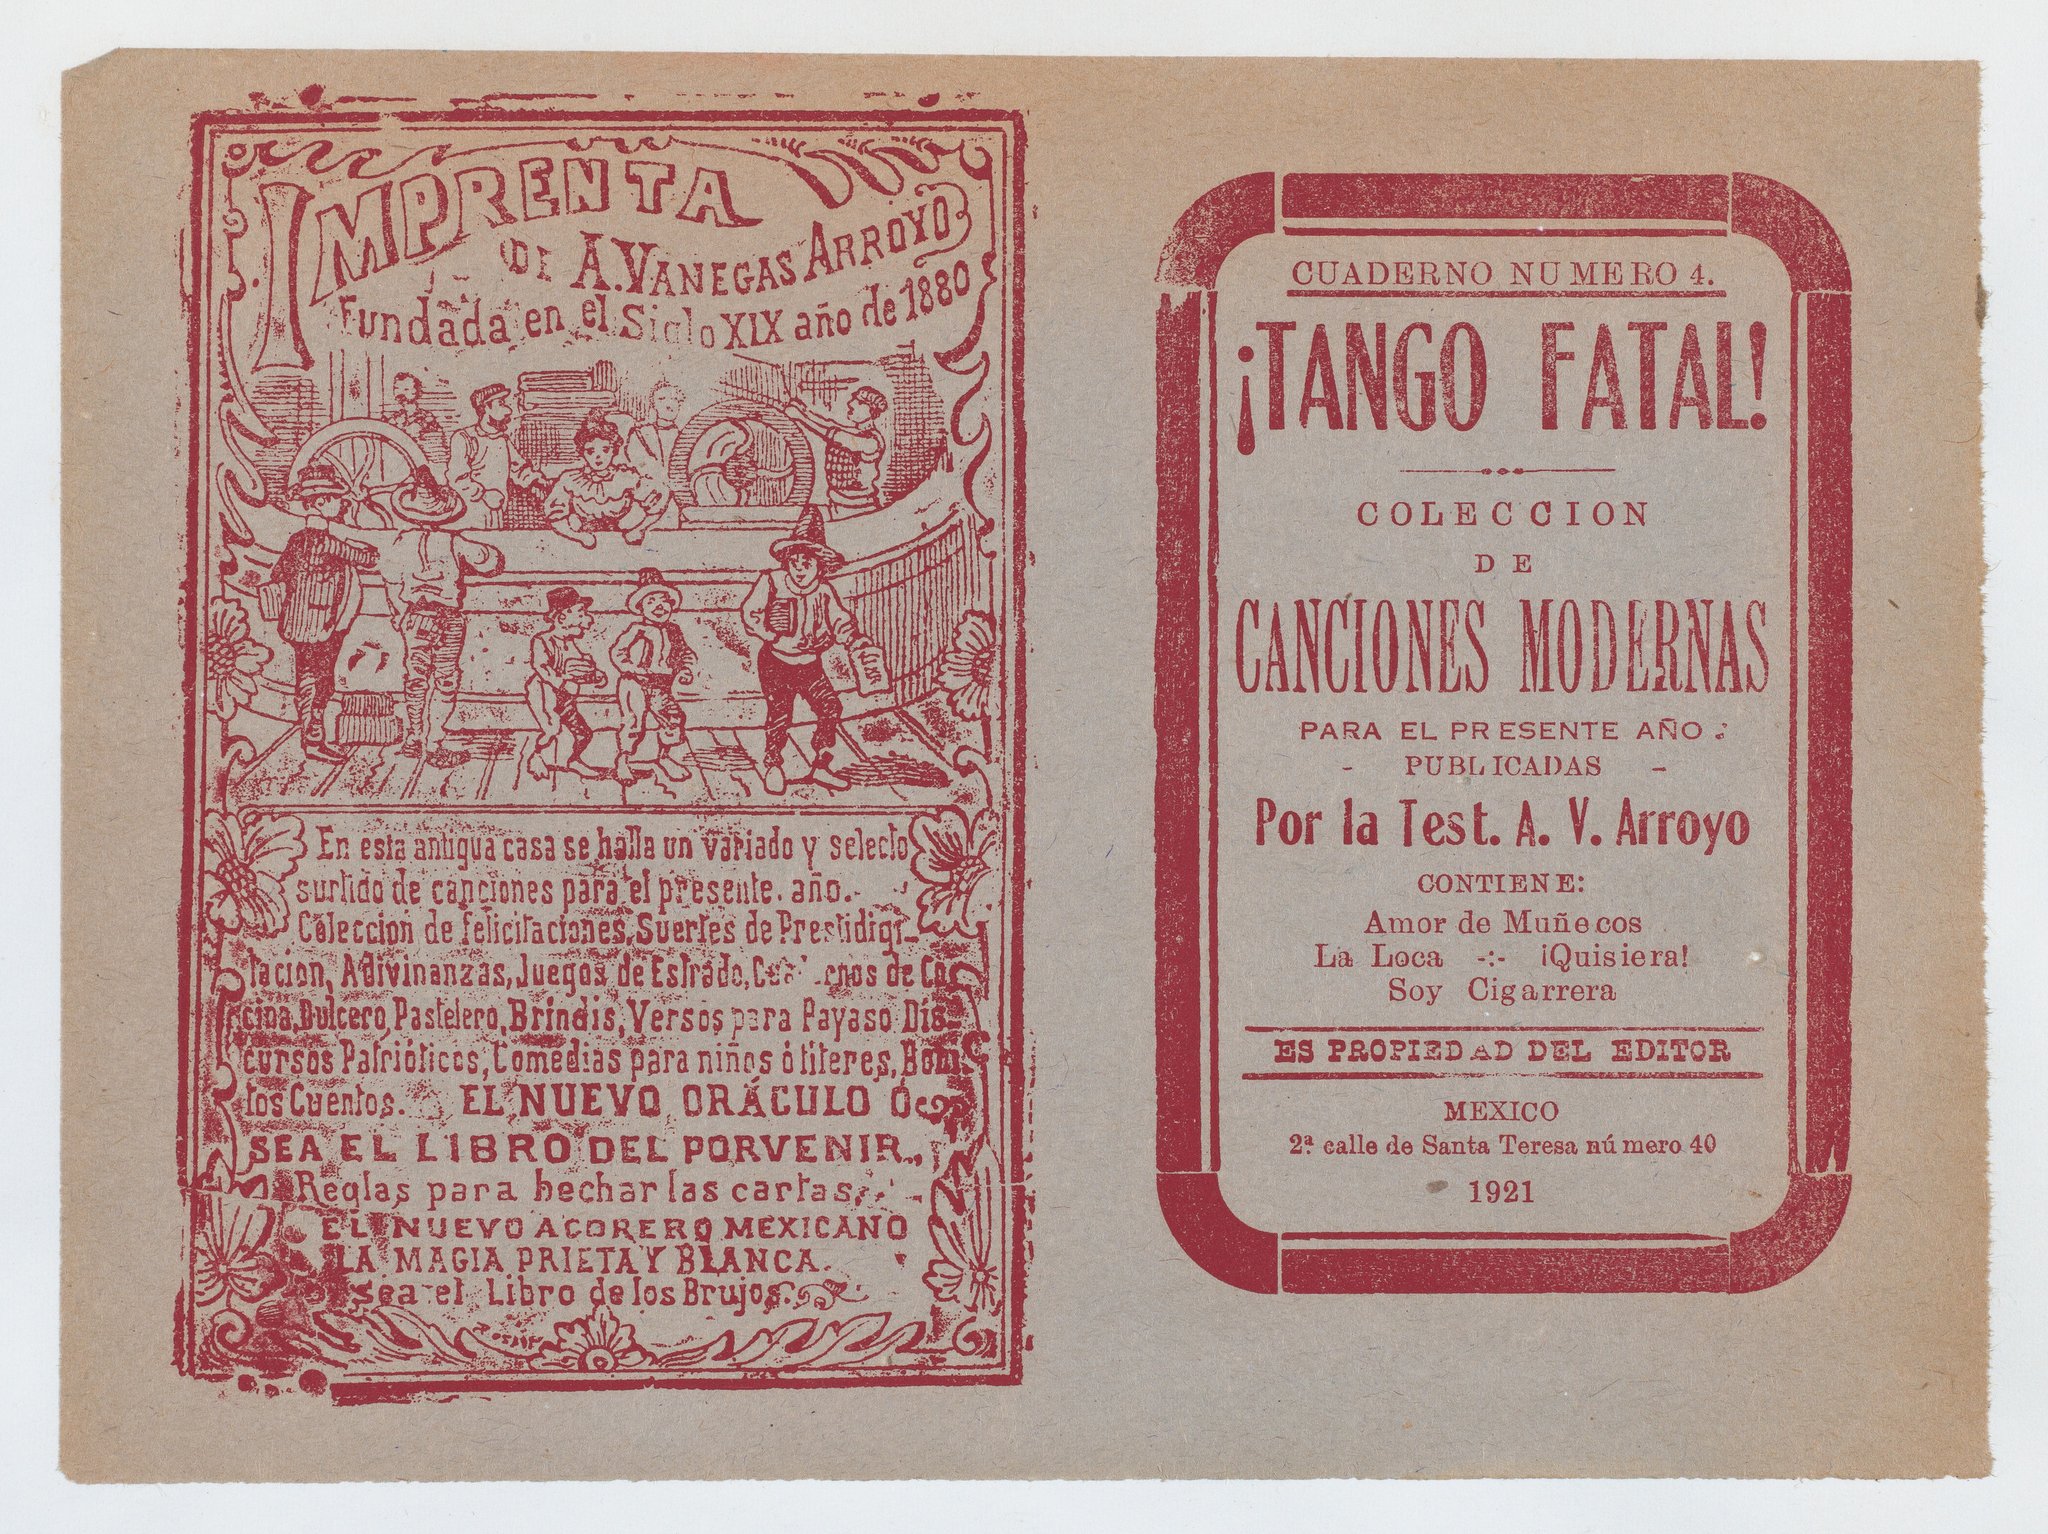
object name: print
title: Cover for 'Tango Fatal! Coleccion de Canciones Modernas'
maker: josé guadalupe posada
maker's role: artist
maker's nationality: mexican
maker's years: 1852-1913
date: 1921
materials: paper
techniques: letterpress, printing, lithography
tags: children,men,women